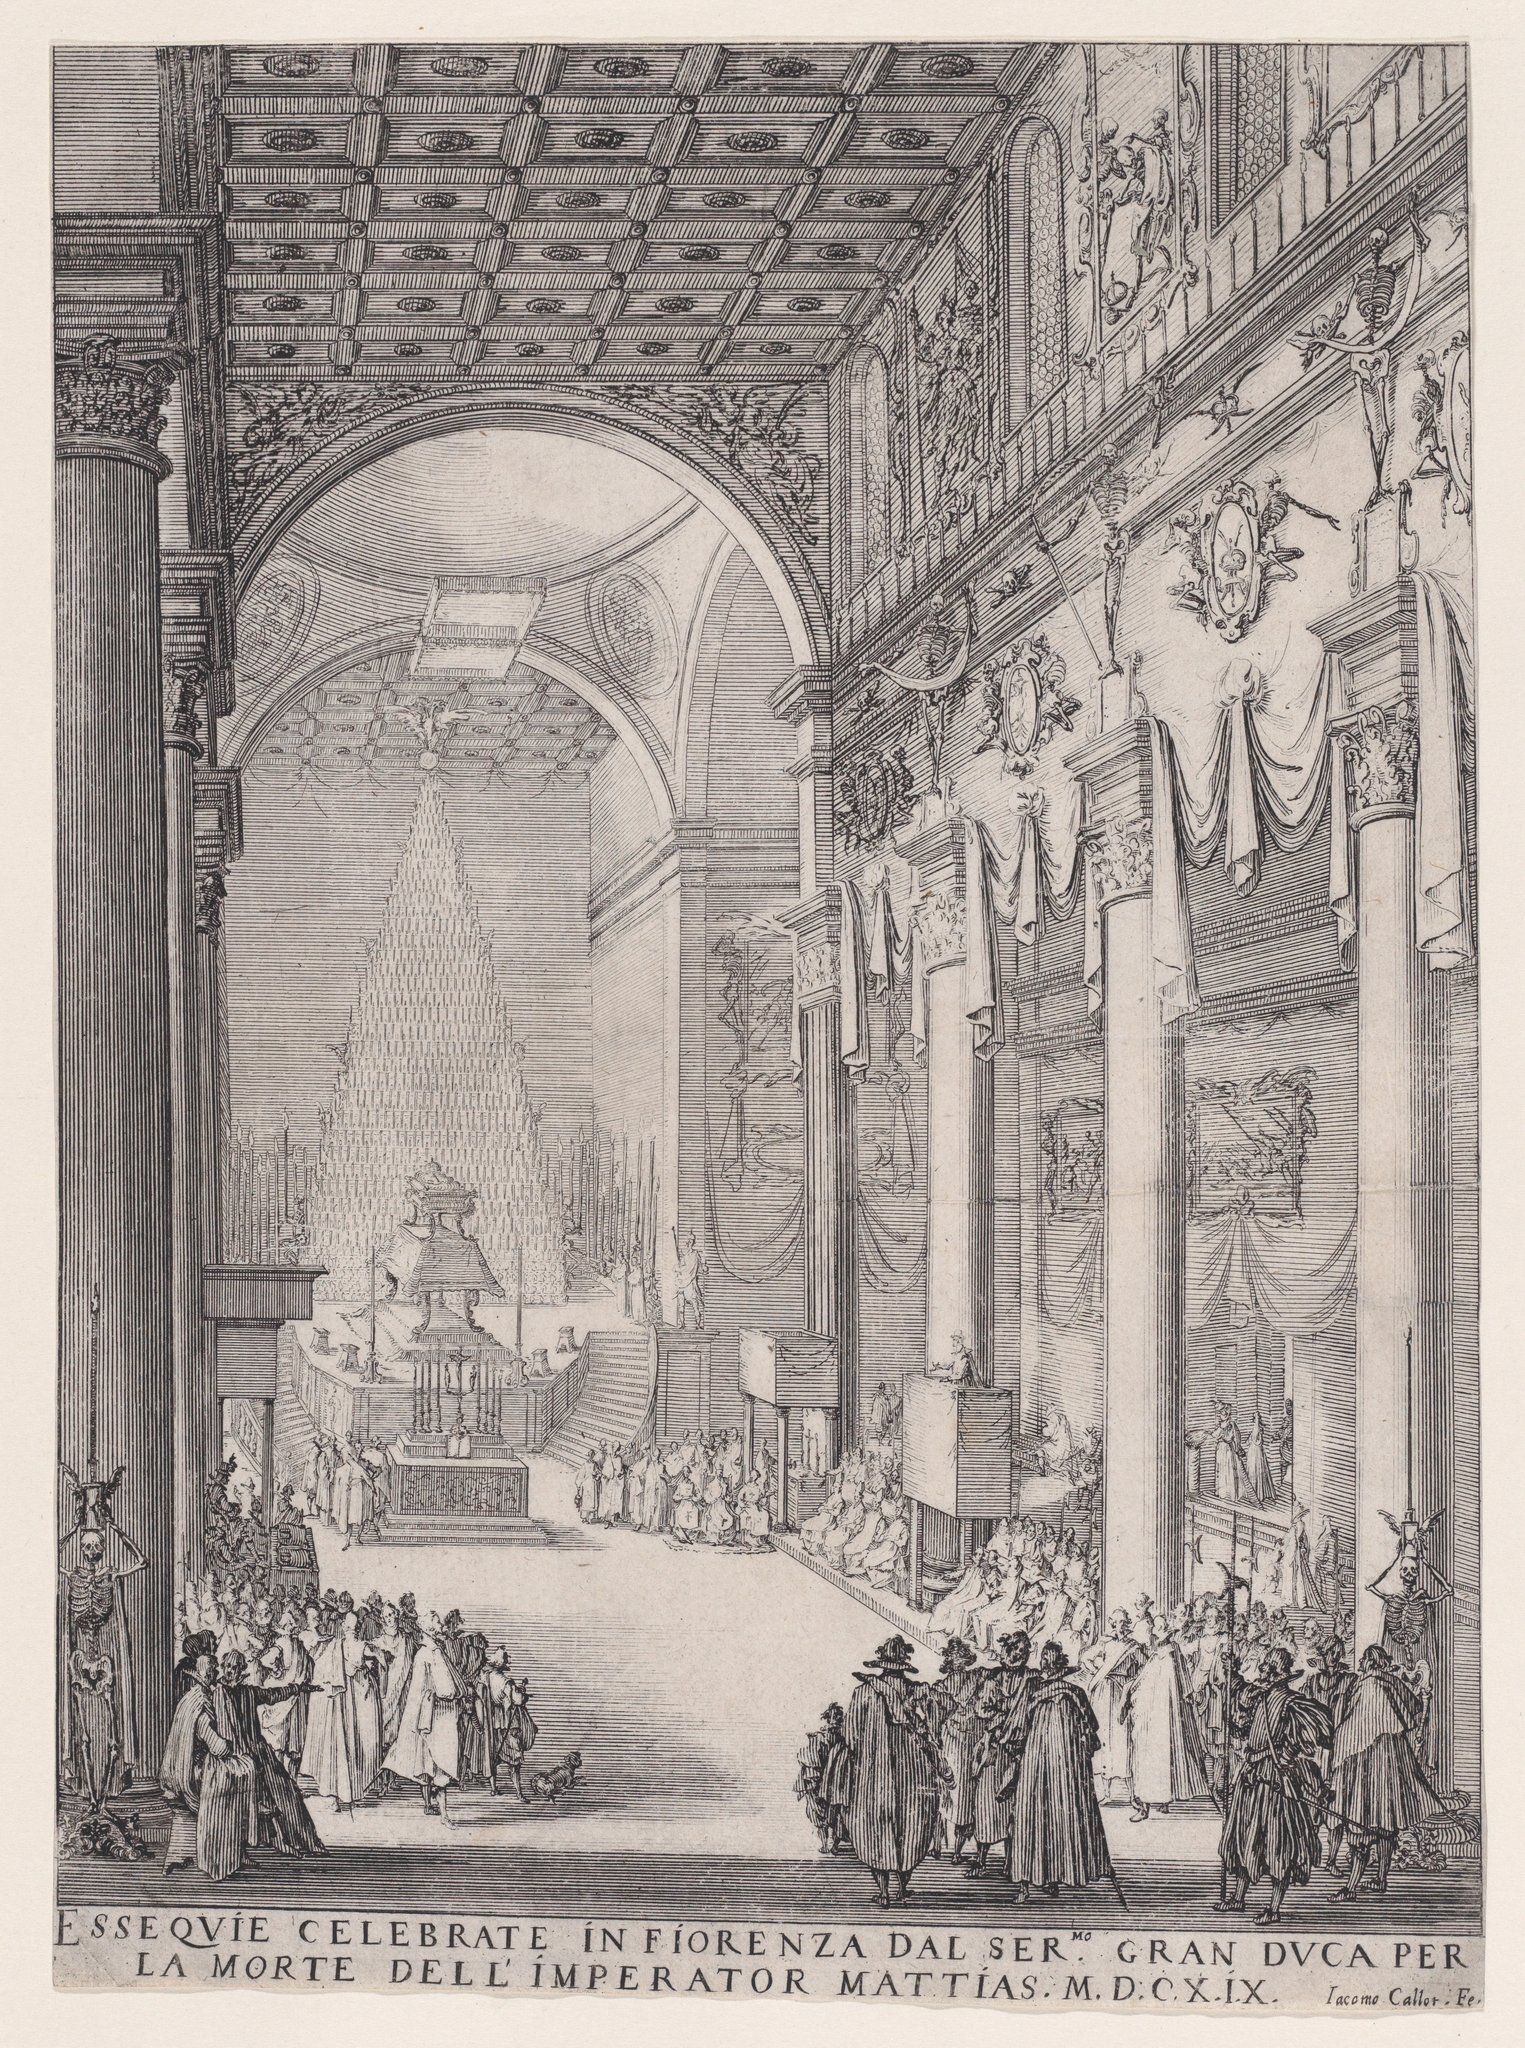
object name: print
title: Le Catafalque de l'Empereur Mathais pièce appelée aussi Le Petit Prédicateur, La Chapelle Funèbre de Florence et Requiem de L'Empereur Mathais (The Catafalque of the Emperor Matthais, piece also called The Small Preacher, The Funerary Chapel of Florence, The Requiem of the Emperor Matthais)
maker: jacques callot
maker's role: artist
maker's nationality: french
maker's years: 1592-1635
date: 1619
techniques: engraving, etching